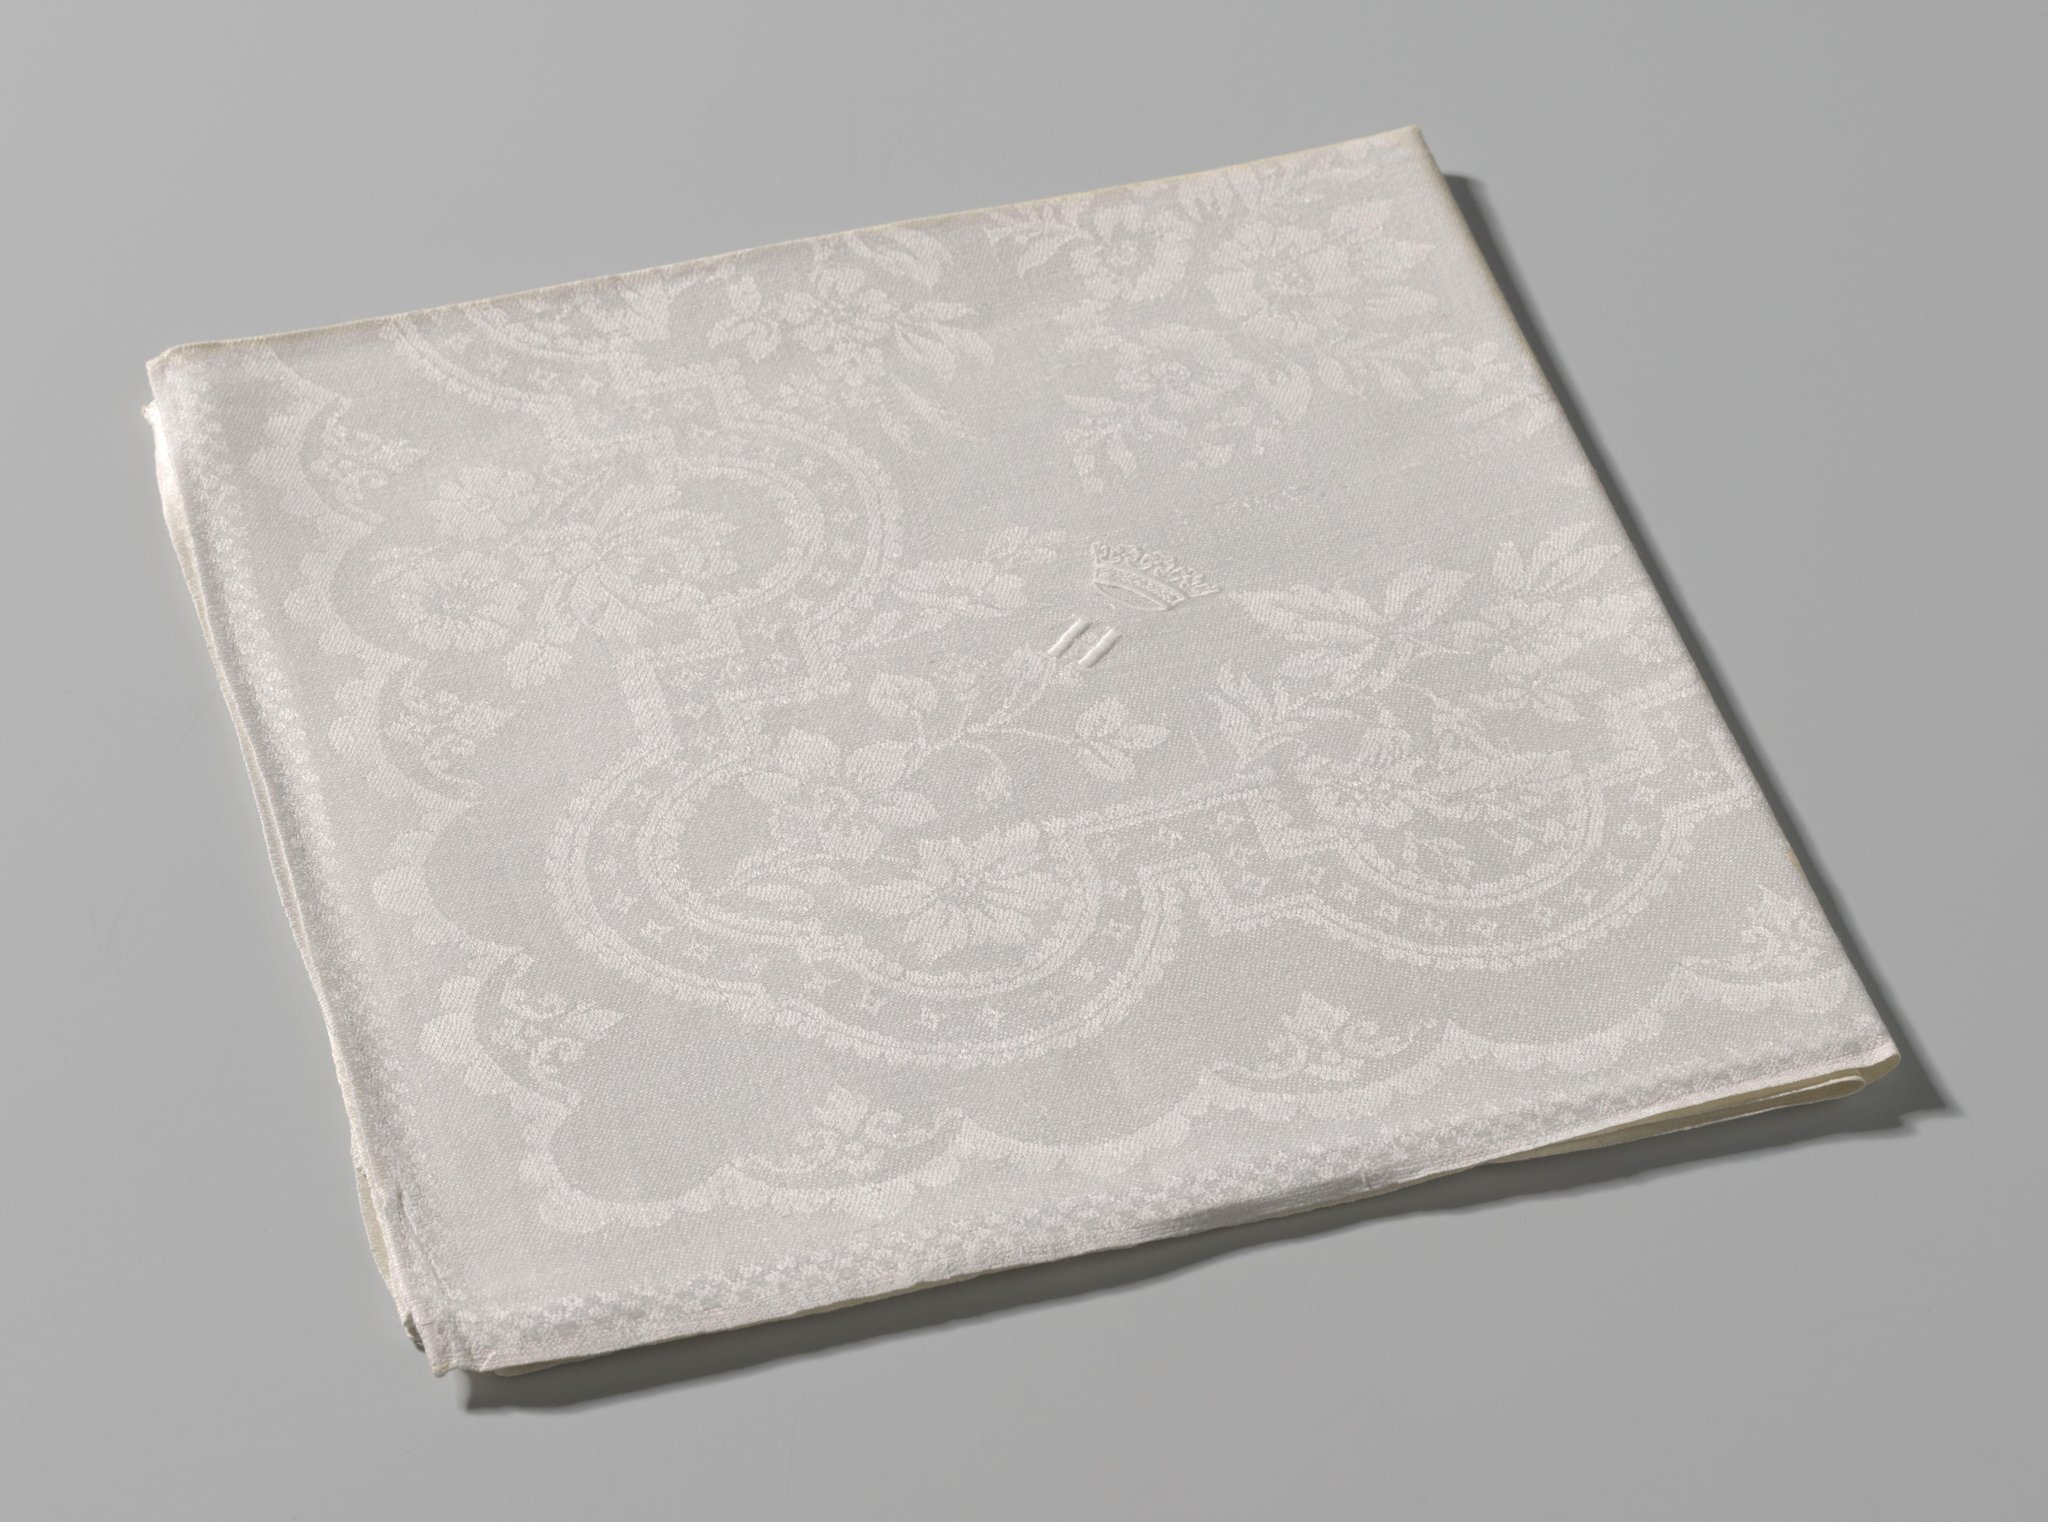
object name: napkin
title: Servet van wit linnendamast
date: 1859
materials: linen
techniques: damask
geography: borne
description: Wit linnen damasten servet met "gebloemde ruit", merk kroon H en 24.